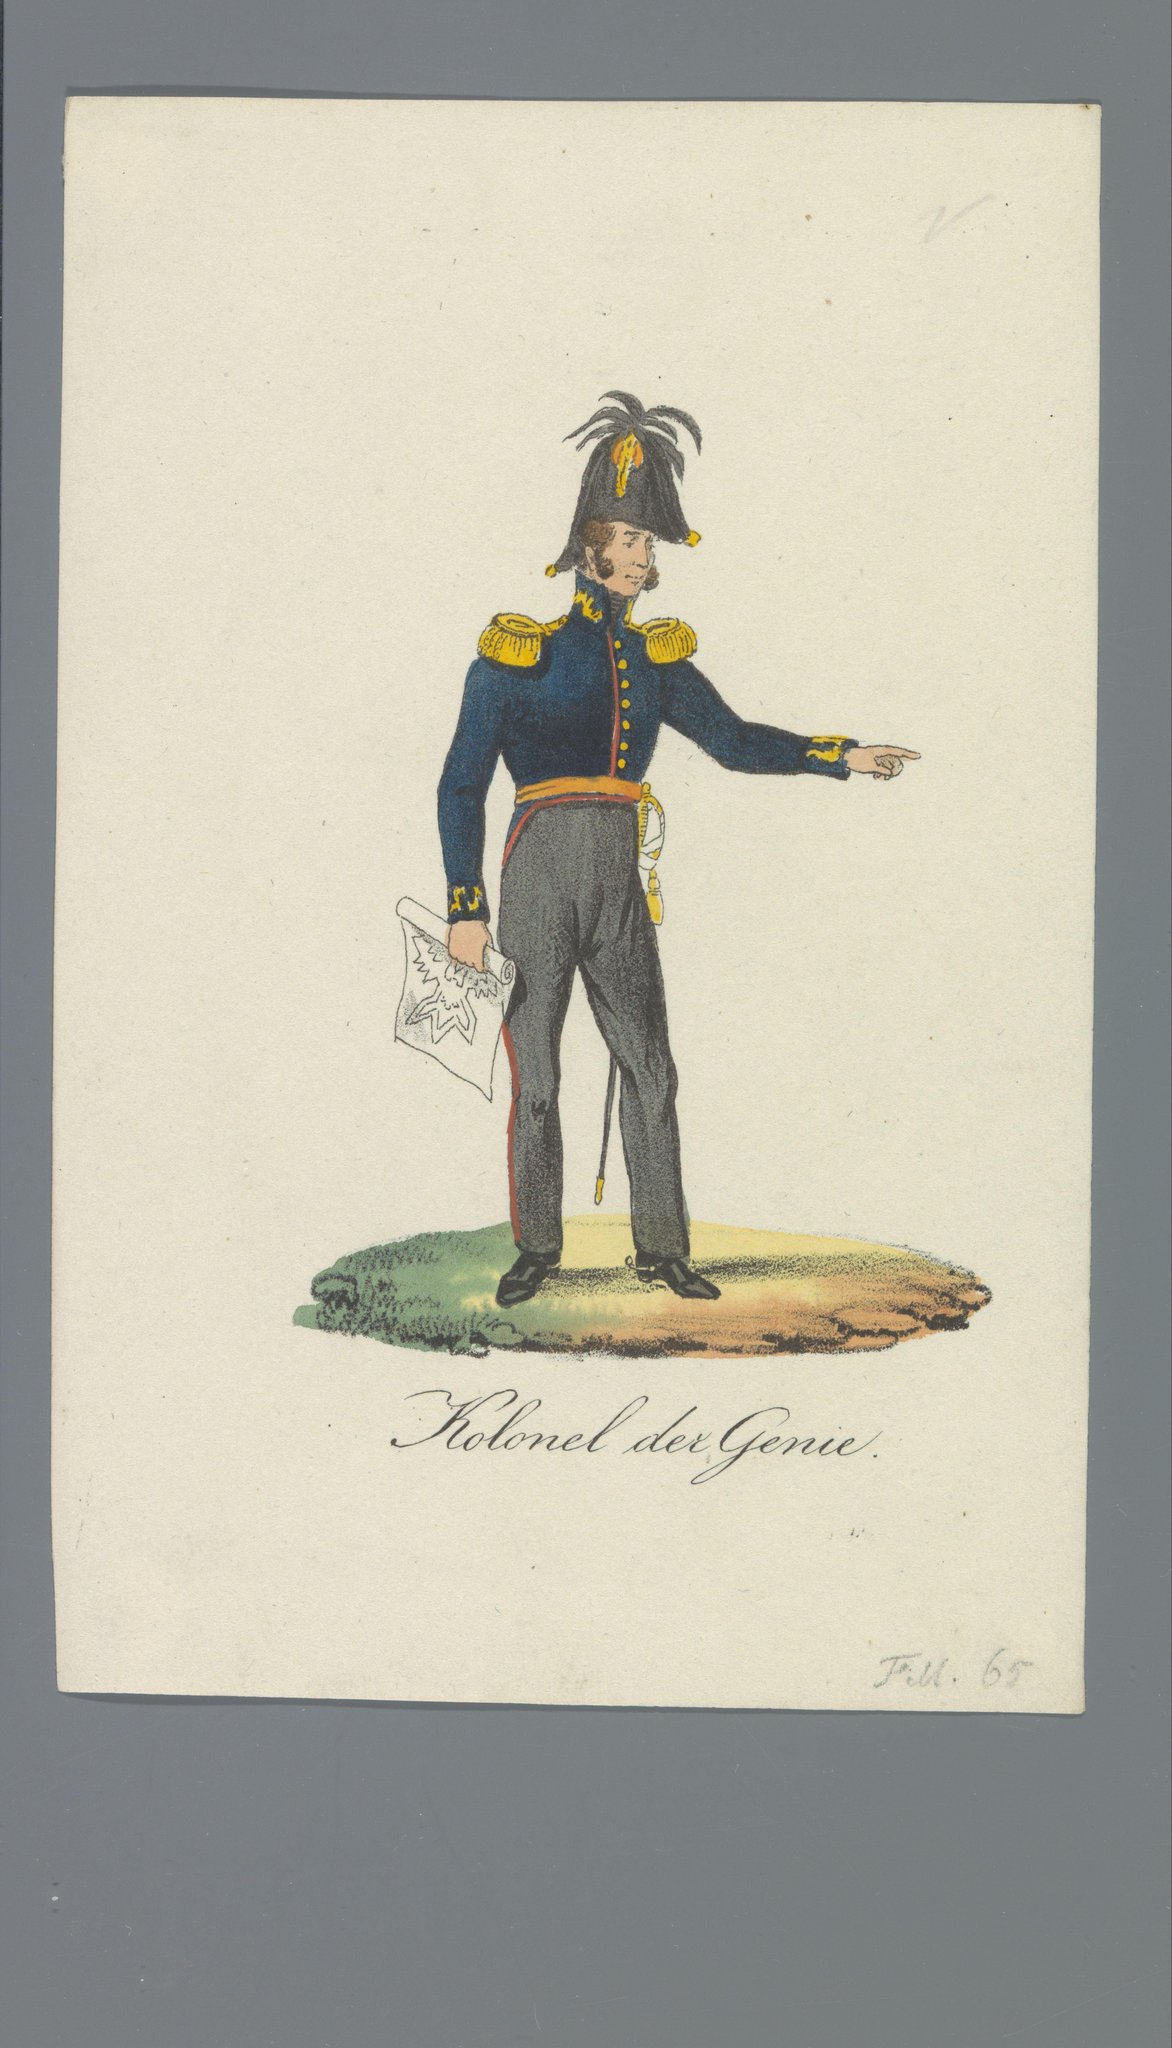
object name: print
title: Kolonel der genie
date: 1835-1850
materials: paper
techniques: hand coloring, lithograph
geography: utrecht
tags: (military) uniforms, clothes, costume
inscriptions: collector's mark: Lugt 2228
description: Staande kolonel van de genie, met een vestingplan in de hand. Onderdeel van een serie van 157 losse bladen met Nederlandse militaire uniformen in de jaren 1830-1832.